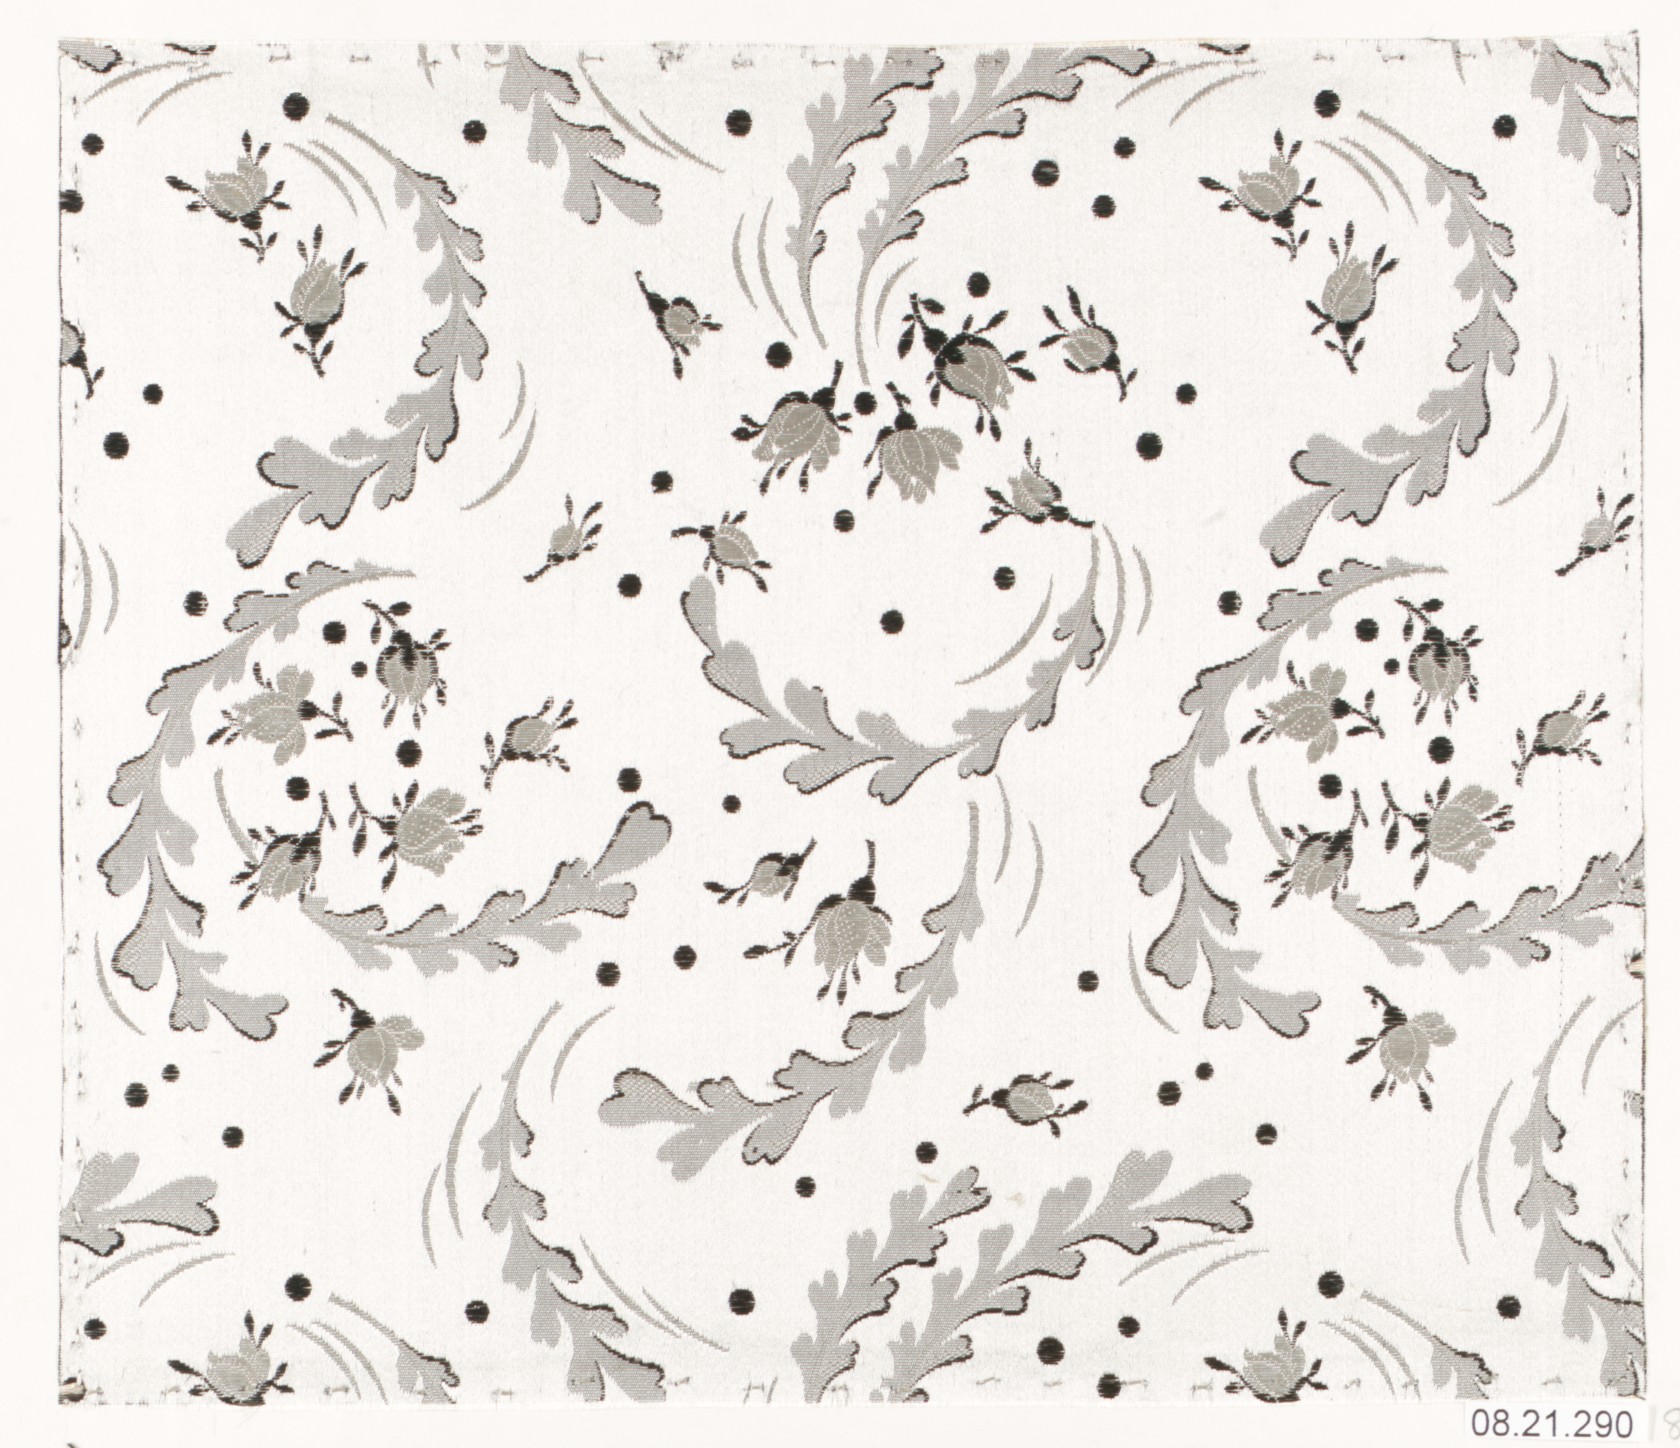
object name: textile sample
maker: Anonymous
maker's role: designer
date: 1900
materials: silk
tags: flowers,leaves